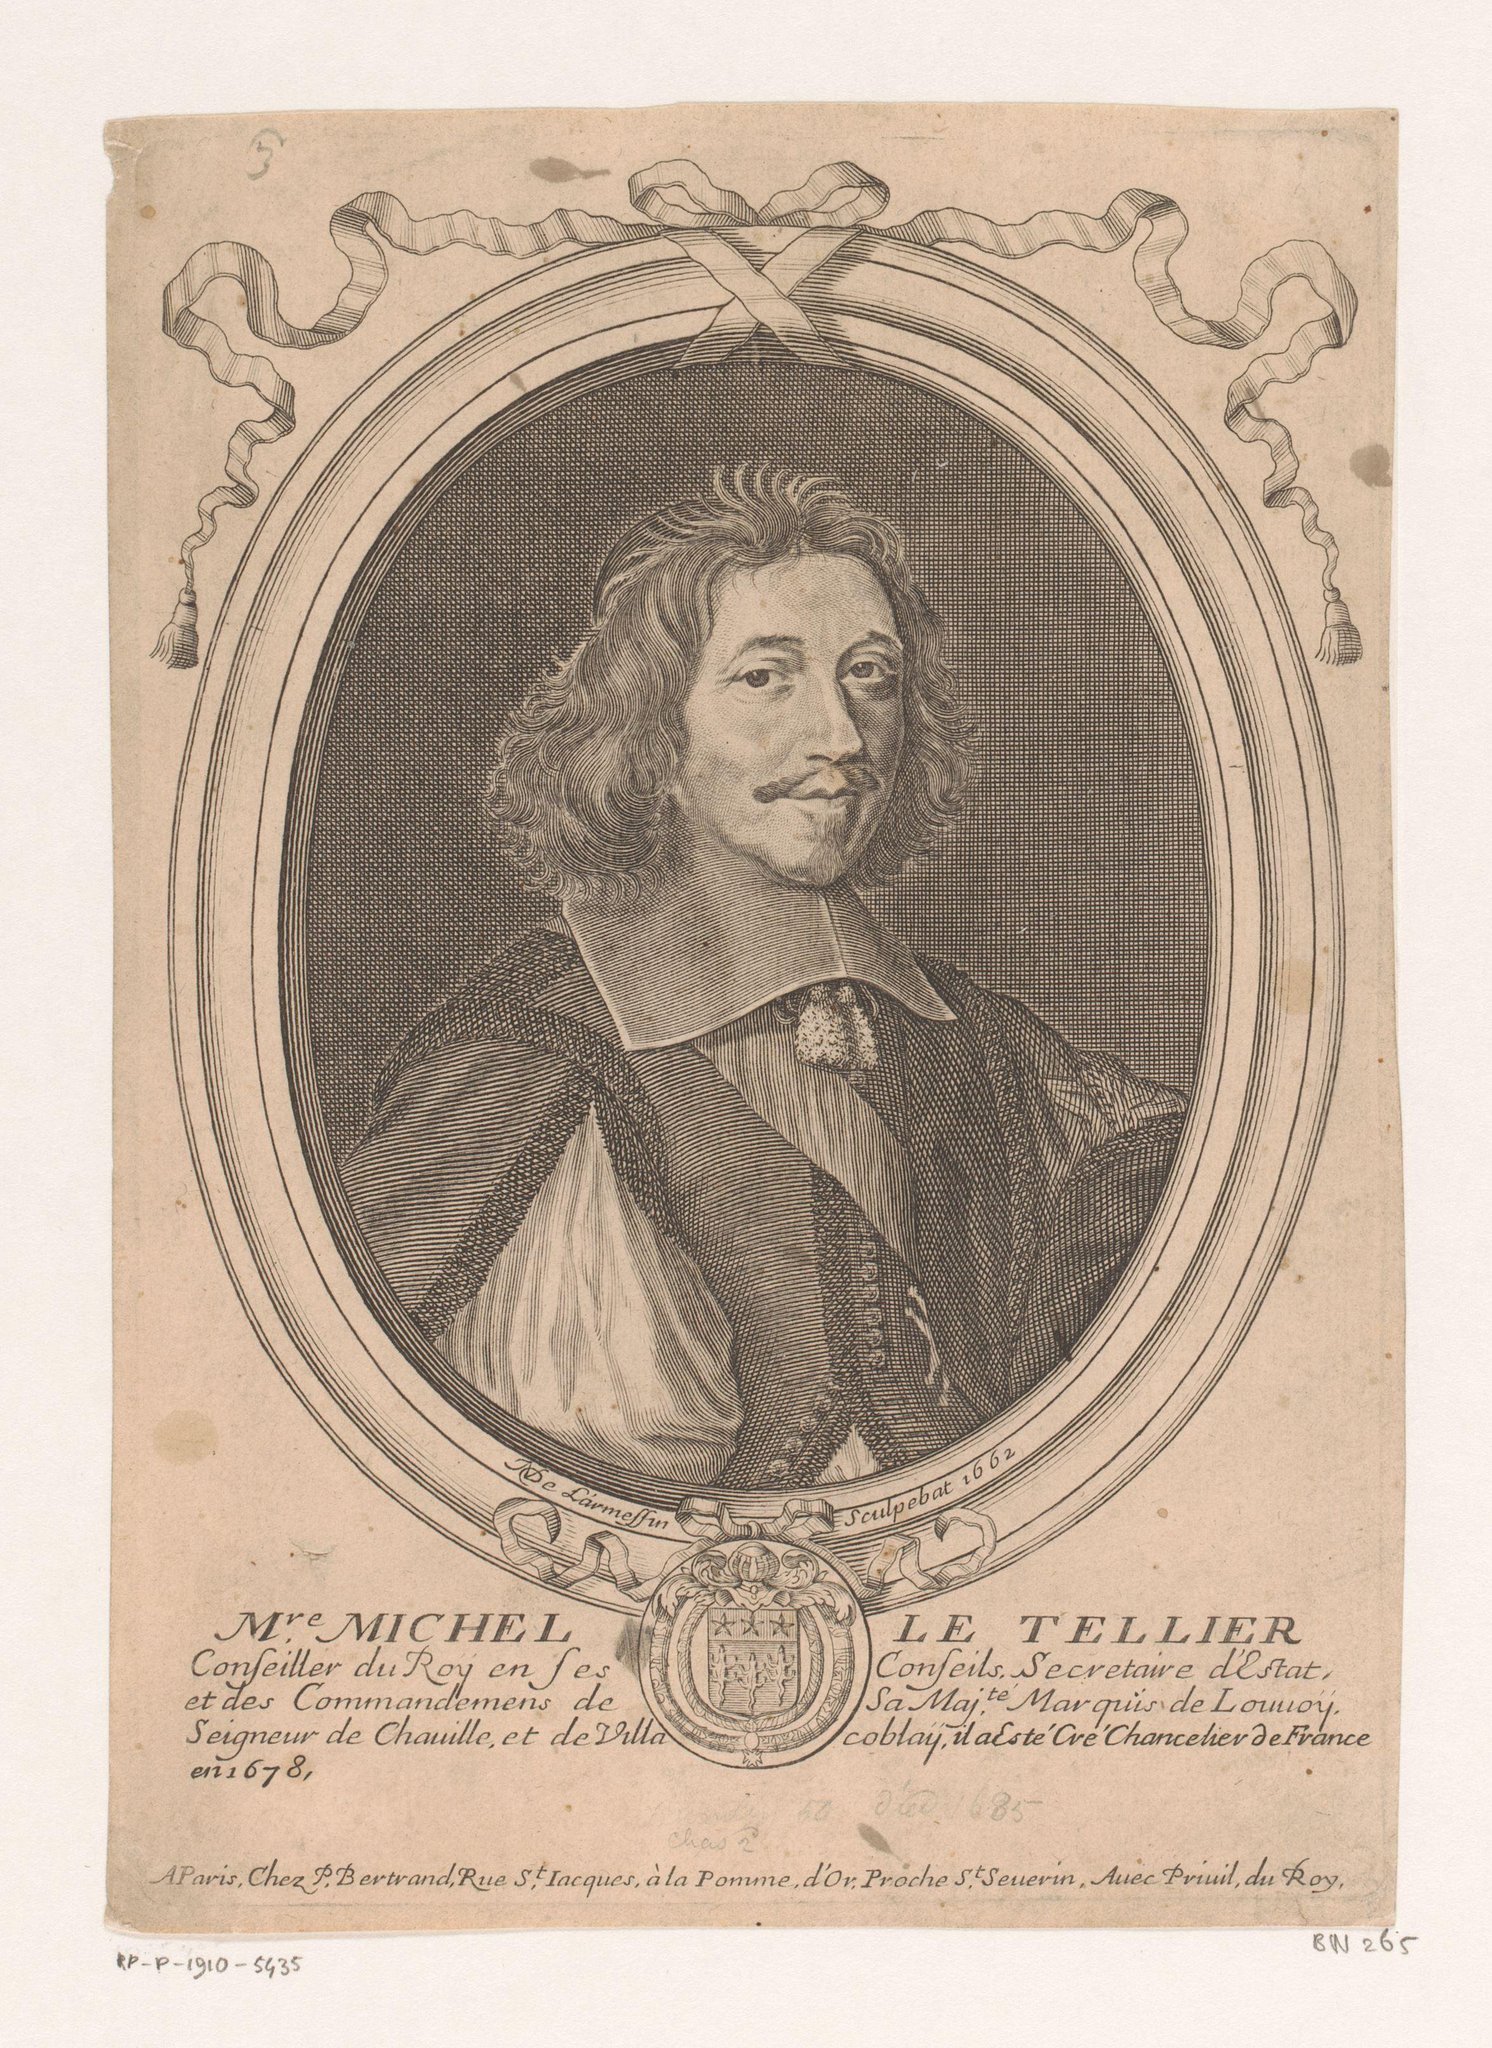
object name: print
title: Portret van Michel Le Tellier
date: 1642-1678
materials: paper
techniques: engraving, etching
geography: paris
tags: paris, michel le tellier, historical persons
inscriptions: collector's mark: Lugt 2228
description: Maakt deel uit van een grootschalige serie met portretten van prominente figuren. Binnen de serie bevindt zich een sectie getiteld 'Les Augustes Représentations De tous les Roys De France depuis Pharamond Iusqu'à Louys XIIII'. De serie werd respectievelijk uitgegeven door Pierre Bertrand, door zijn weduwe en door De Larmessin zelf.